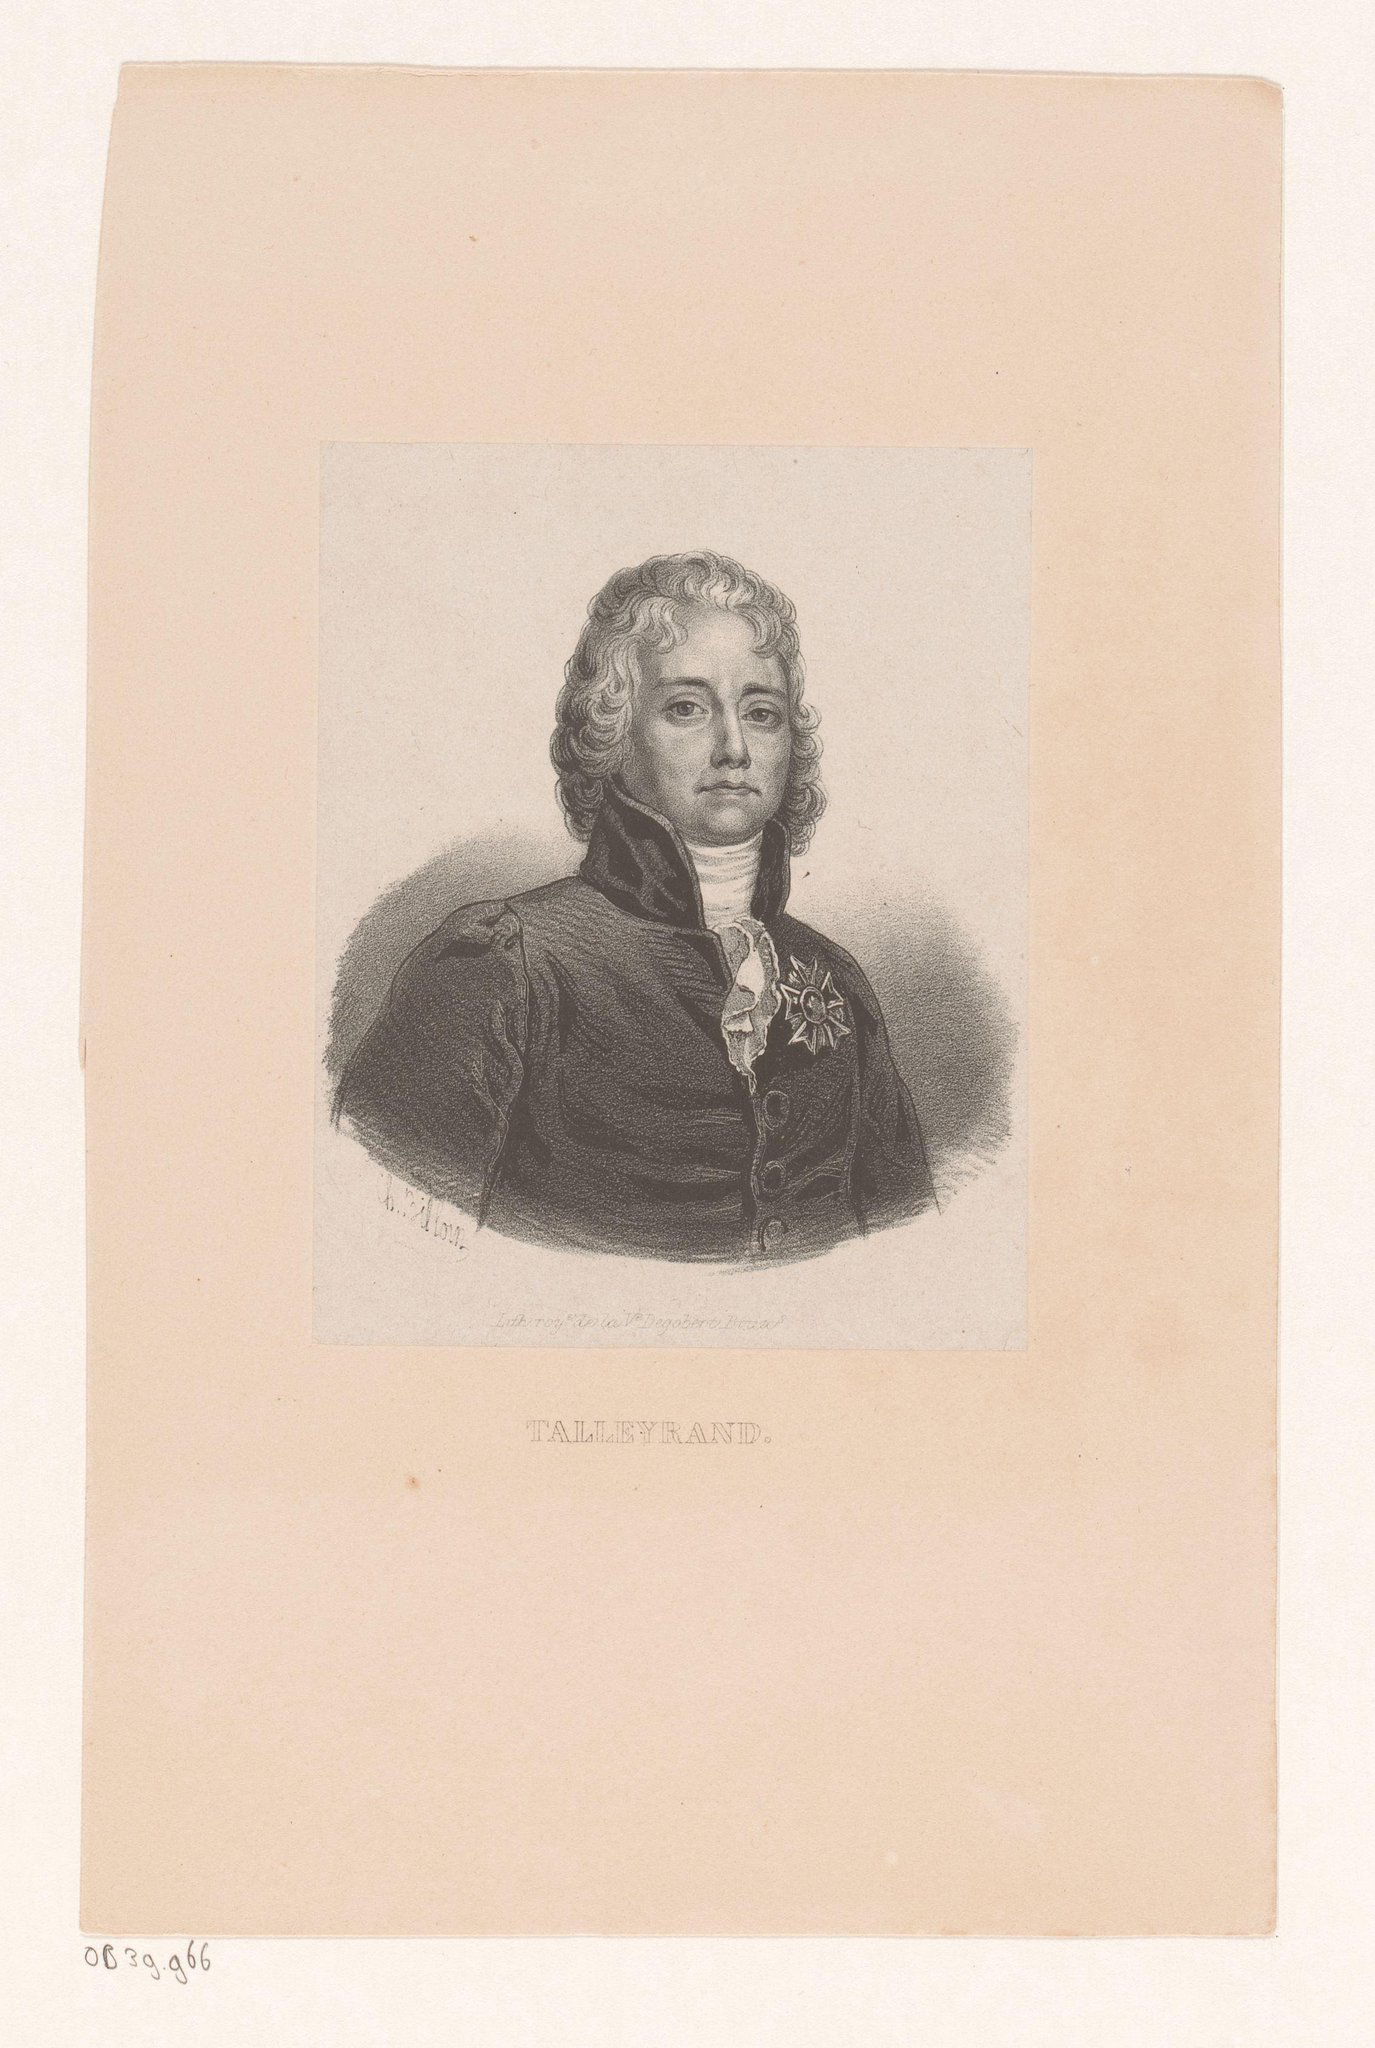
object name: print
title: Portret van Charles Maurice hertog van Talleyrand-Périgord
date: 1823-1850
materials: paper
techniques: lithograph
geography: brussels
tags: politician, charles maurice hertog van talleyrand-périgord, adult man, historical persons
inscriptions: collector's mark: Lugt 2228